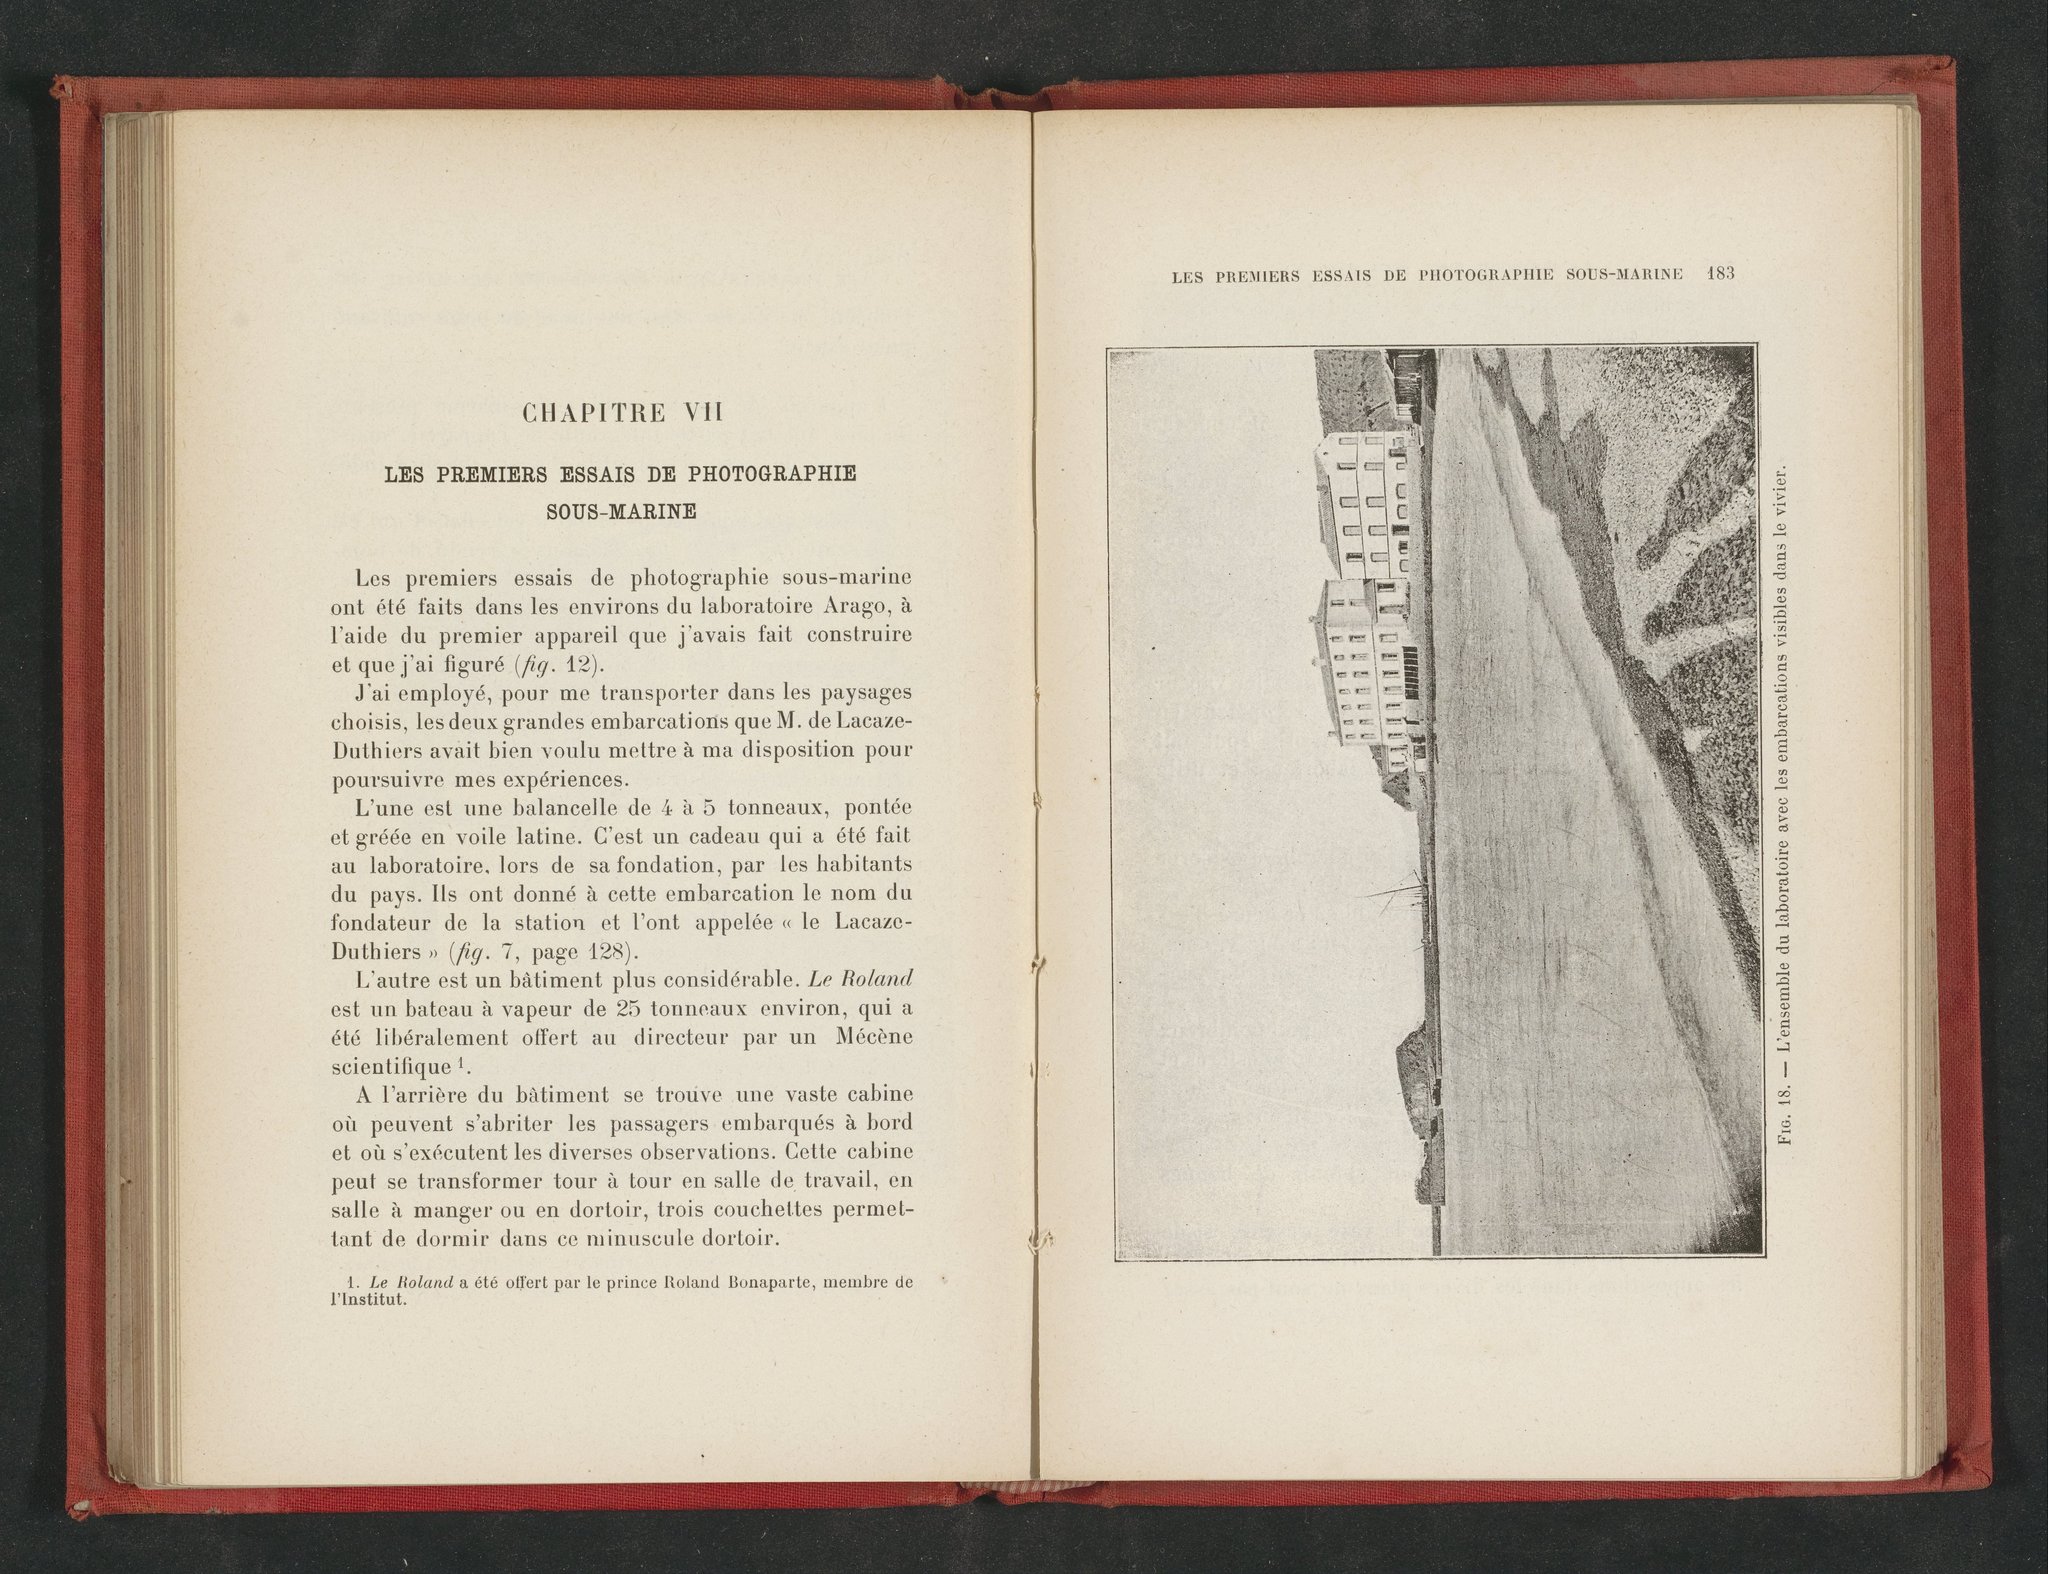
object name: page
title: Paysage sous-marin (pose 1")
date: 1890-1900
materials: paper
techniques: photoaquatint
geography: france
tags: landscapes with waters, waterscapes, seascapes (in the temperate zone)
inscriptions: inscription: ‘Librairie C. Reinwald’, number: ‘Planche VI’